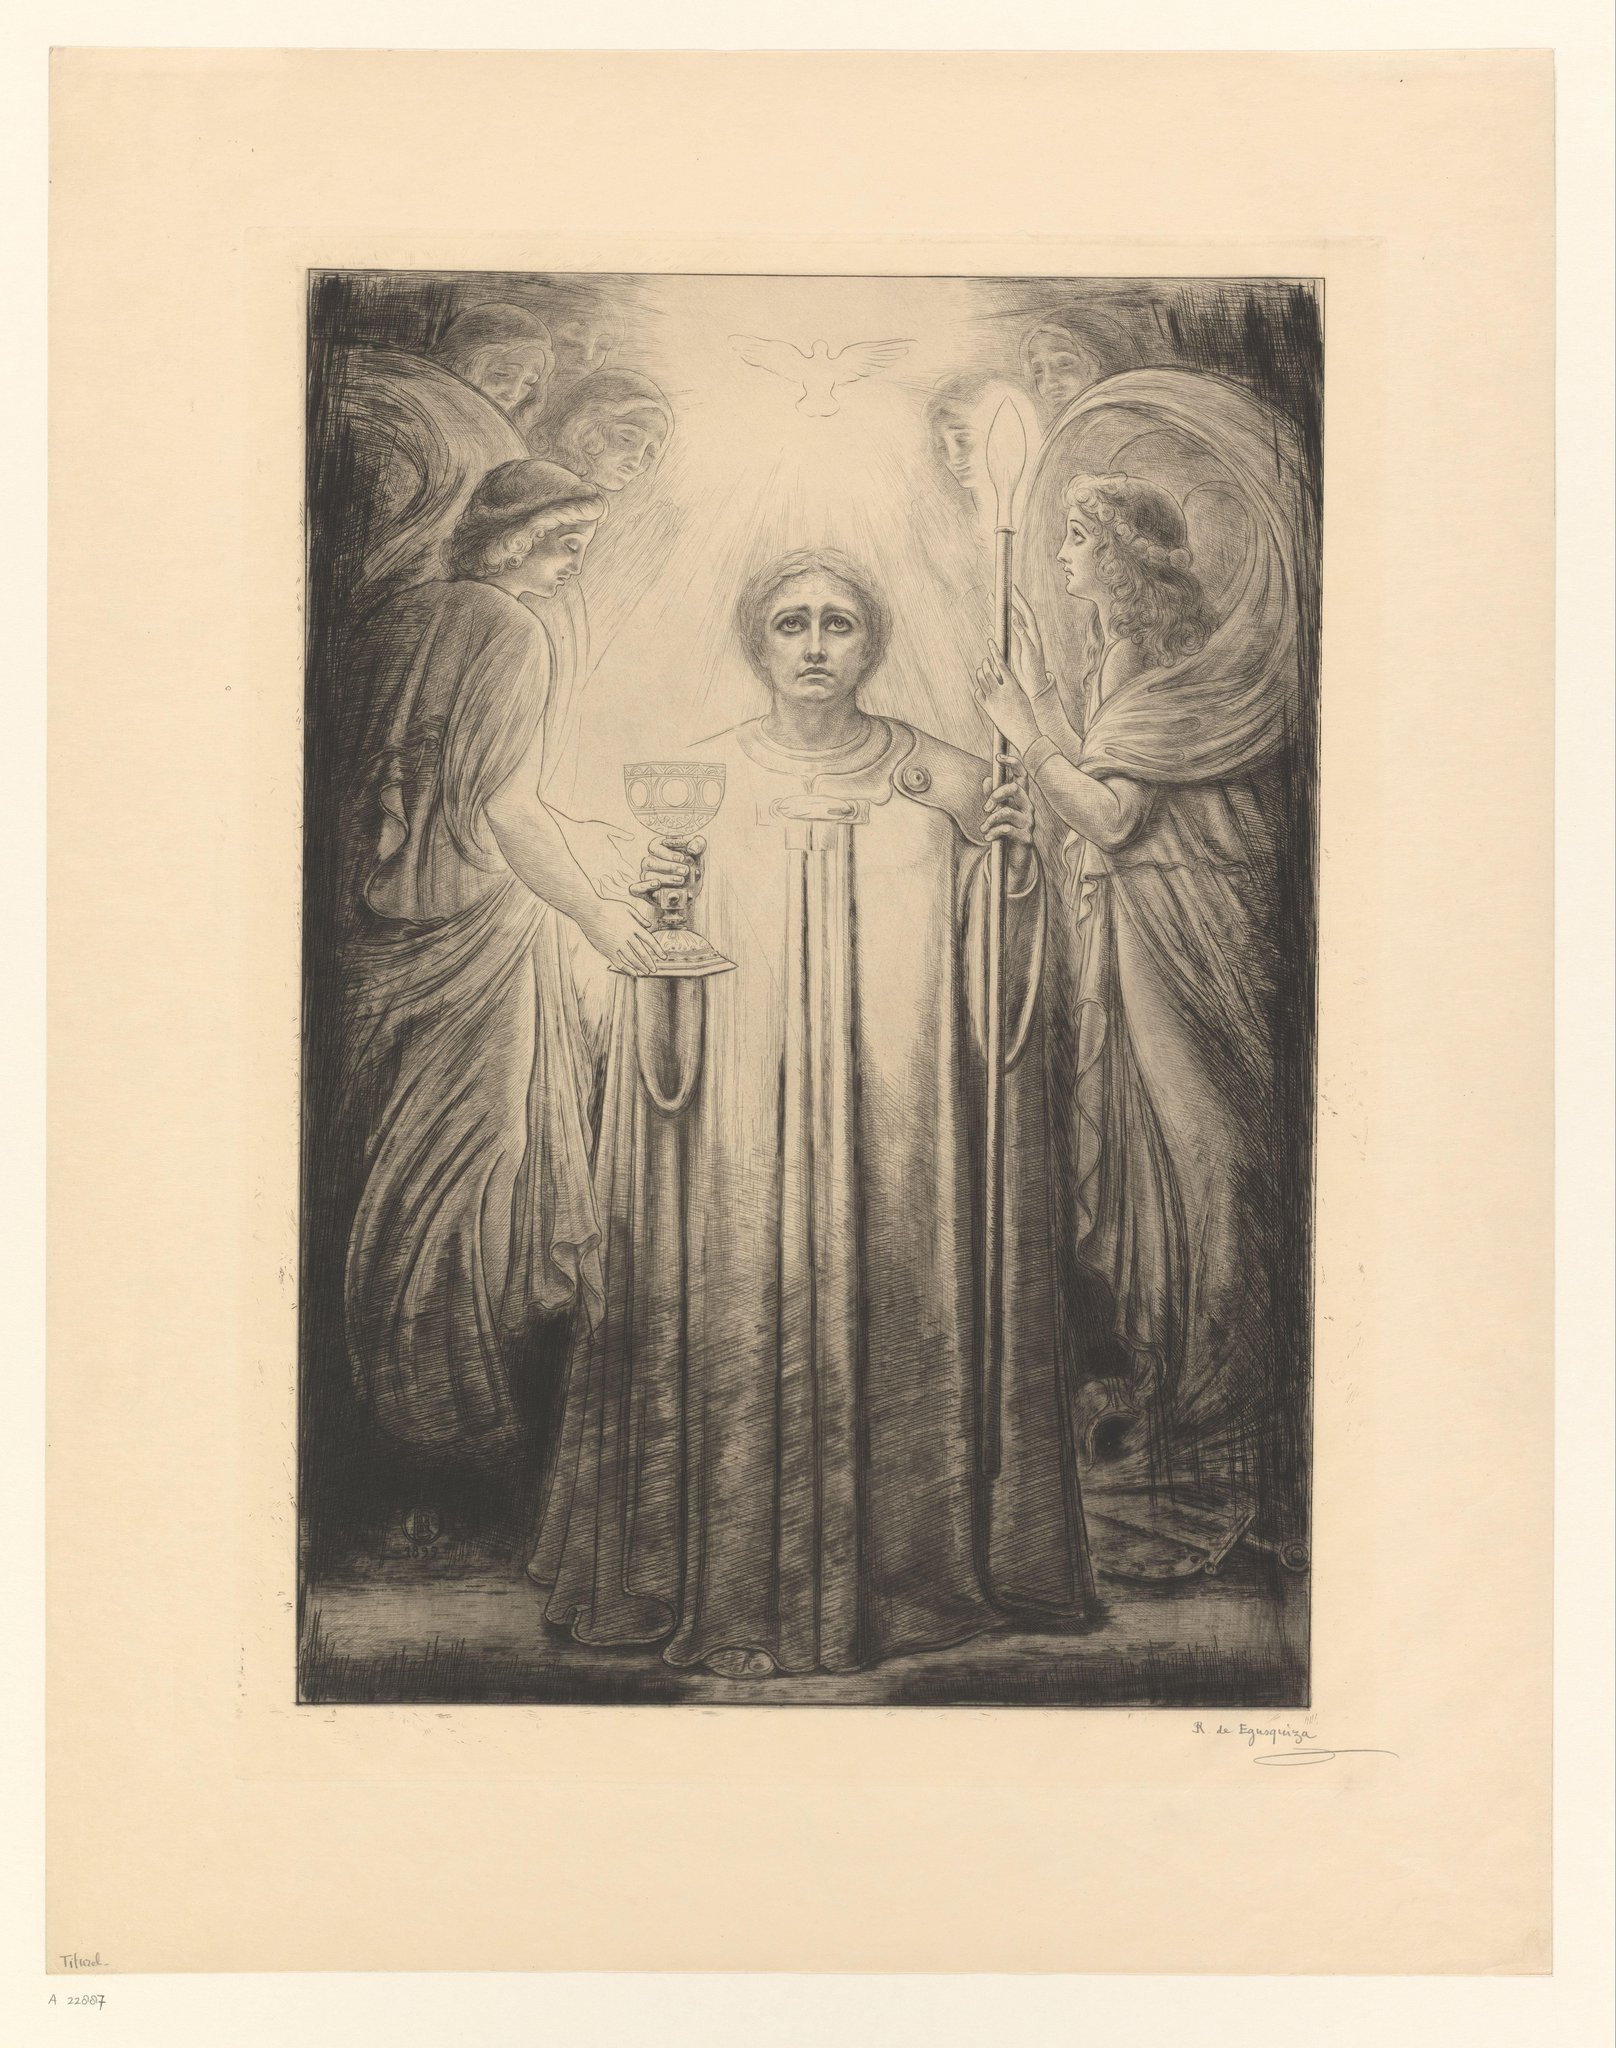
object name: print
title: Titurel omringd door engelen, met de Heilige Graal in de ene en een lans in de andere hand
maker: rogelio de egusquiza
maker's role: painter, print maker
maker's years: 1845-1915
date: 1855-1902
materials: paper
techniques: drypoint, etching, intaglio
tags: lance, spear (symbol of sovereignty), legend of the holy grail, angels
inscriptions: collector's mark: Lugt 2228, annotation: ‘Titurel’